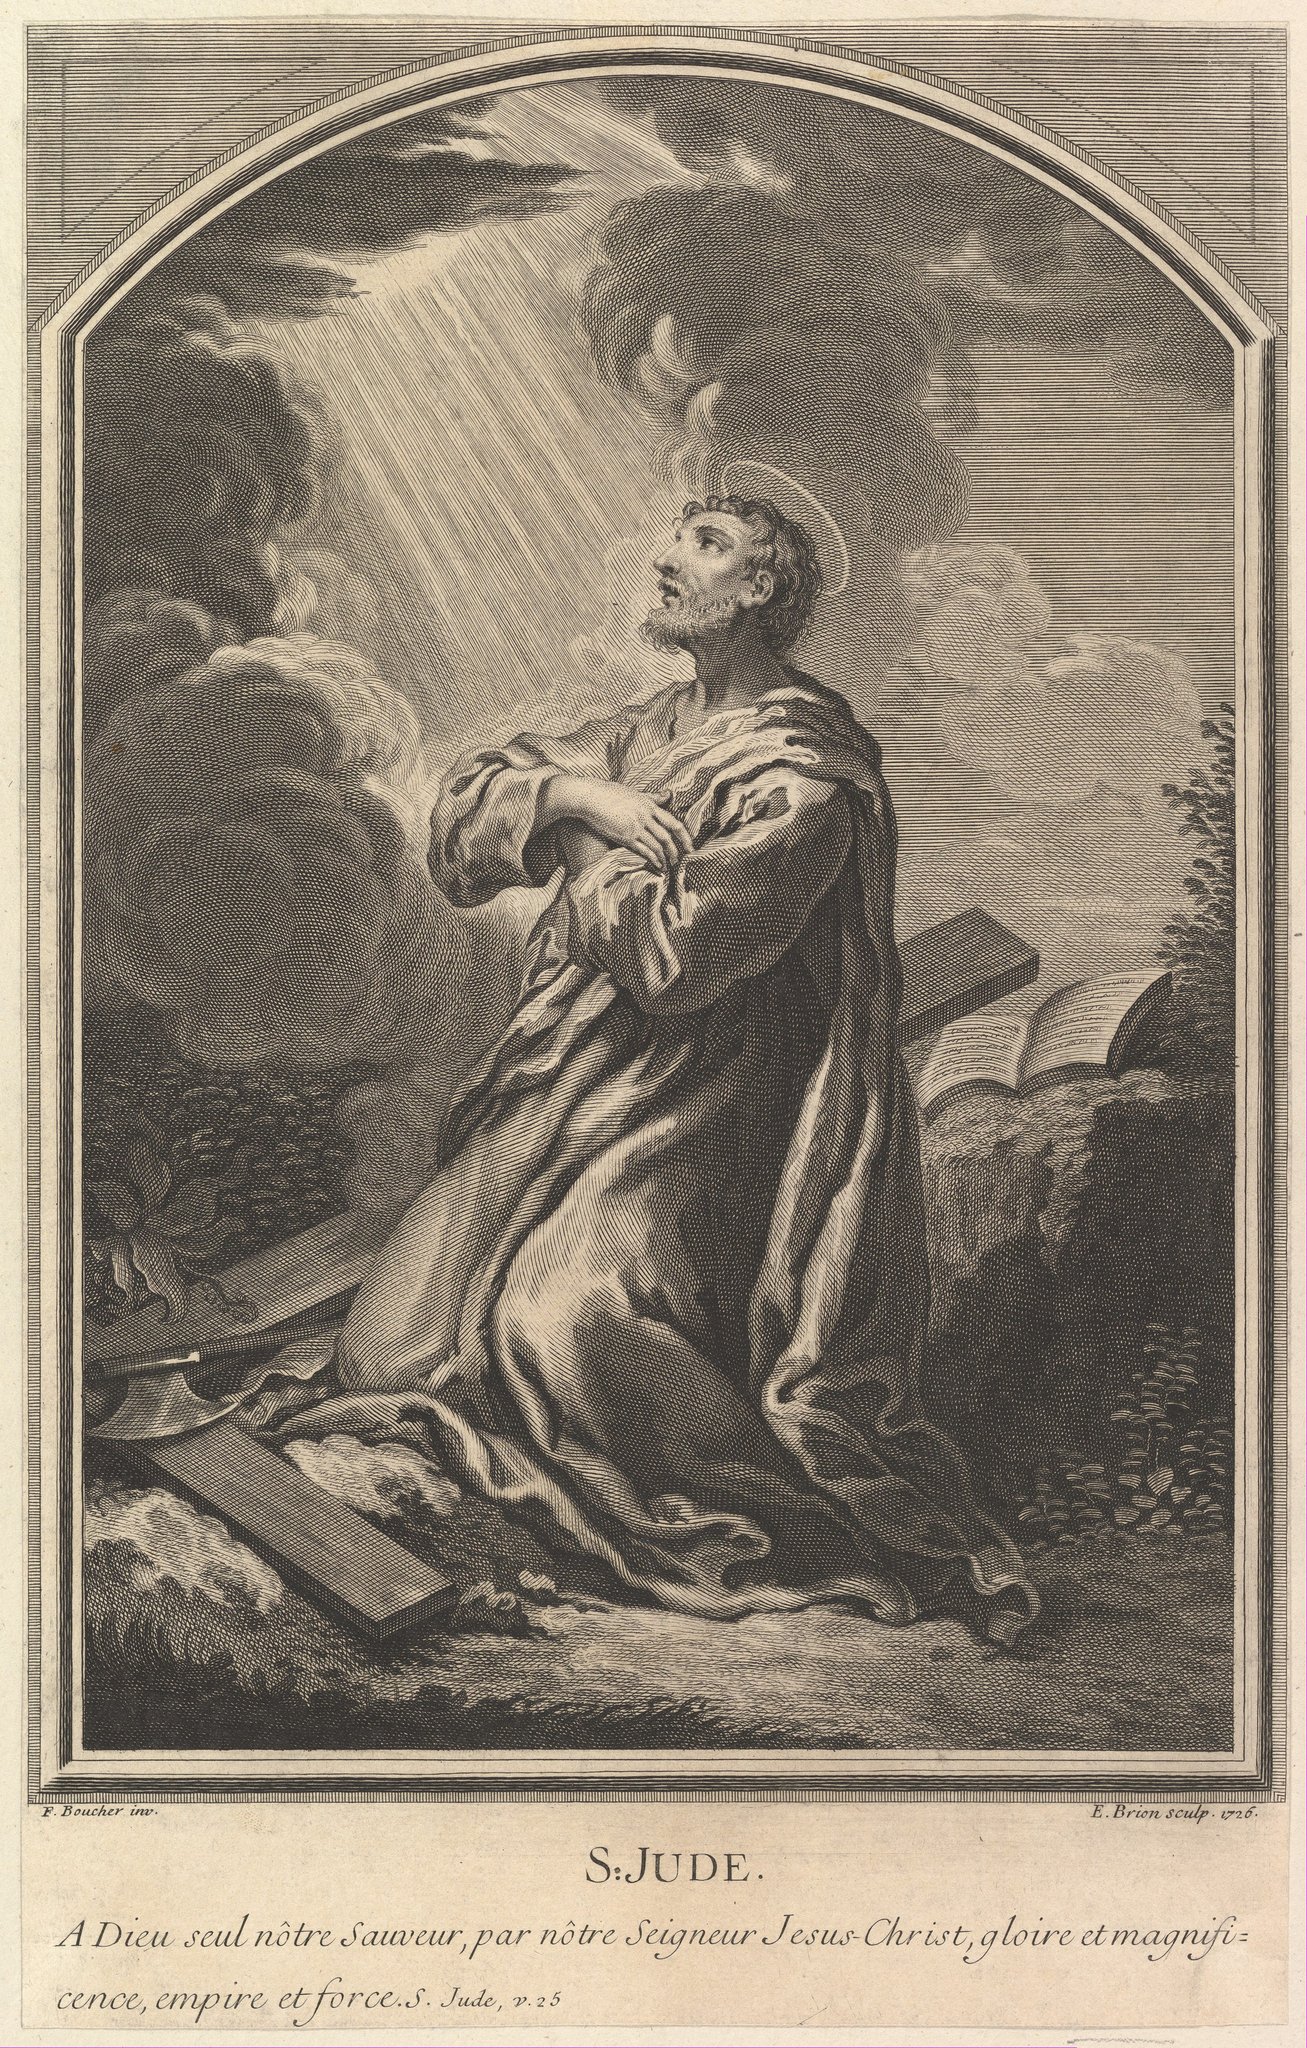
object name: print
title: Saint Jude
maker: etienne brion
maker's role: artist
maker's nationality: french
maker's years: 1700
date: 1726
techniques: engraving, etching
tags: men,saints